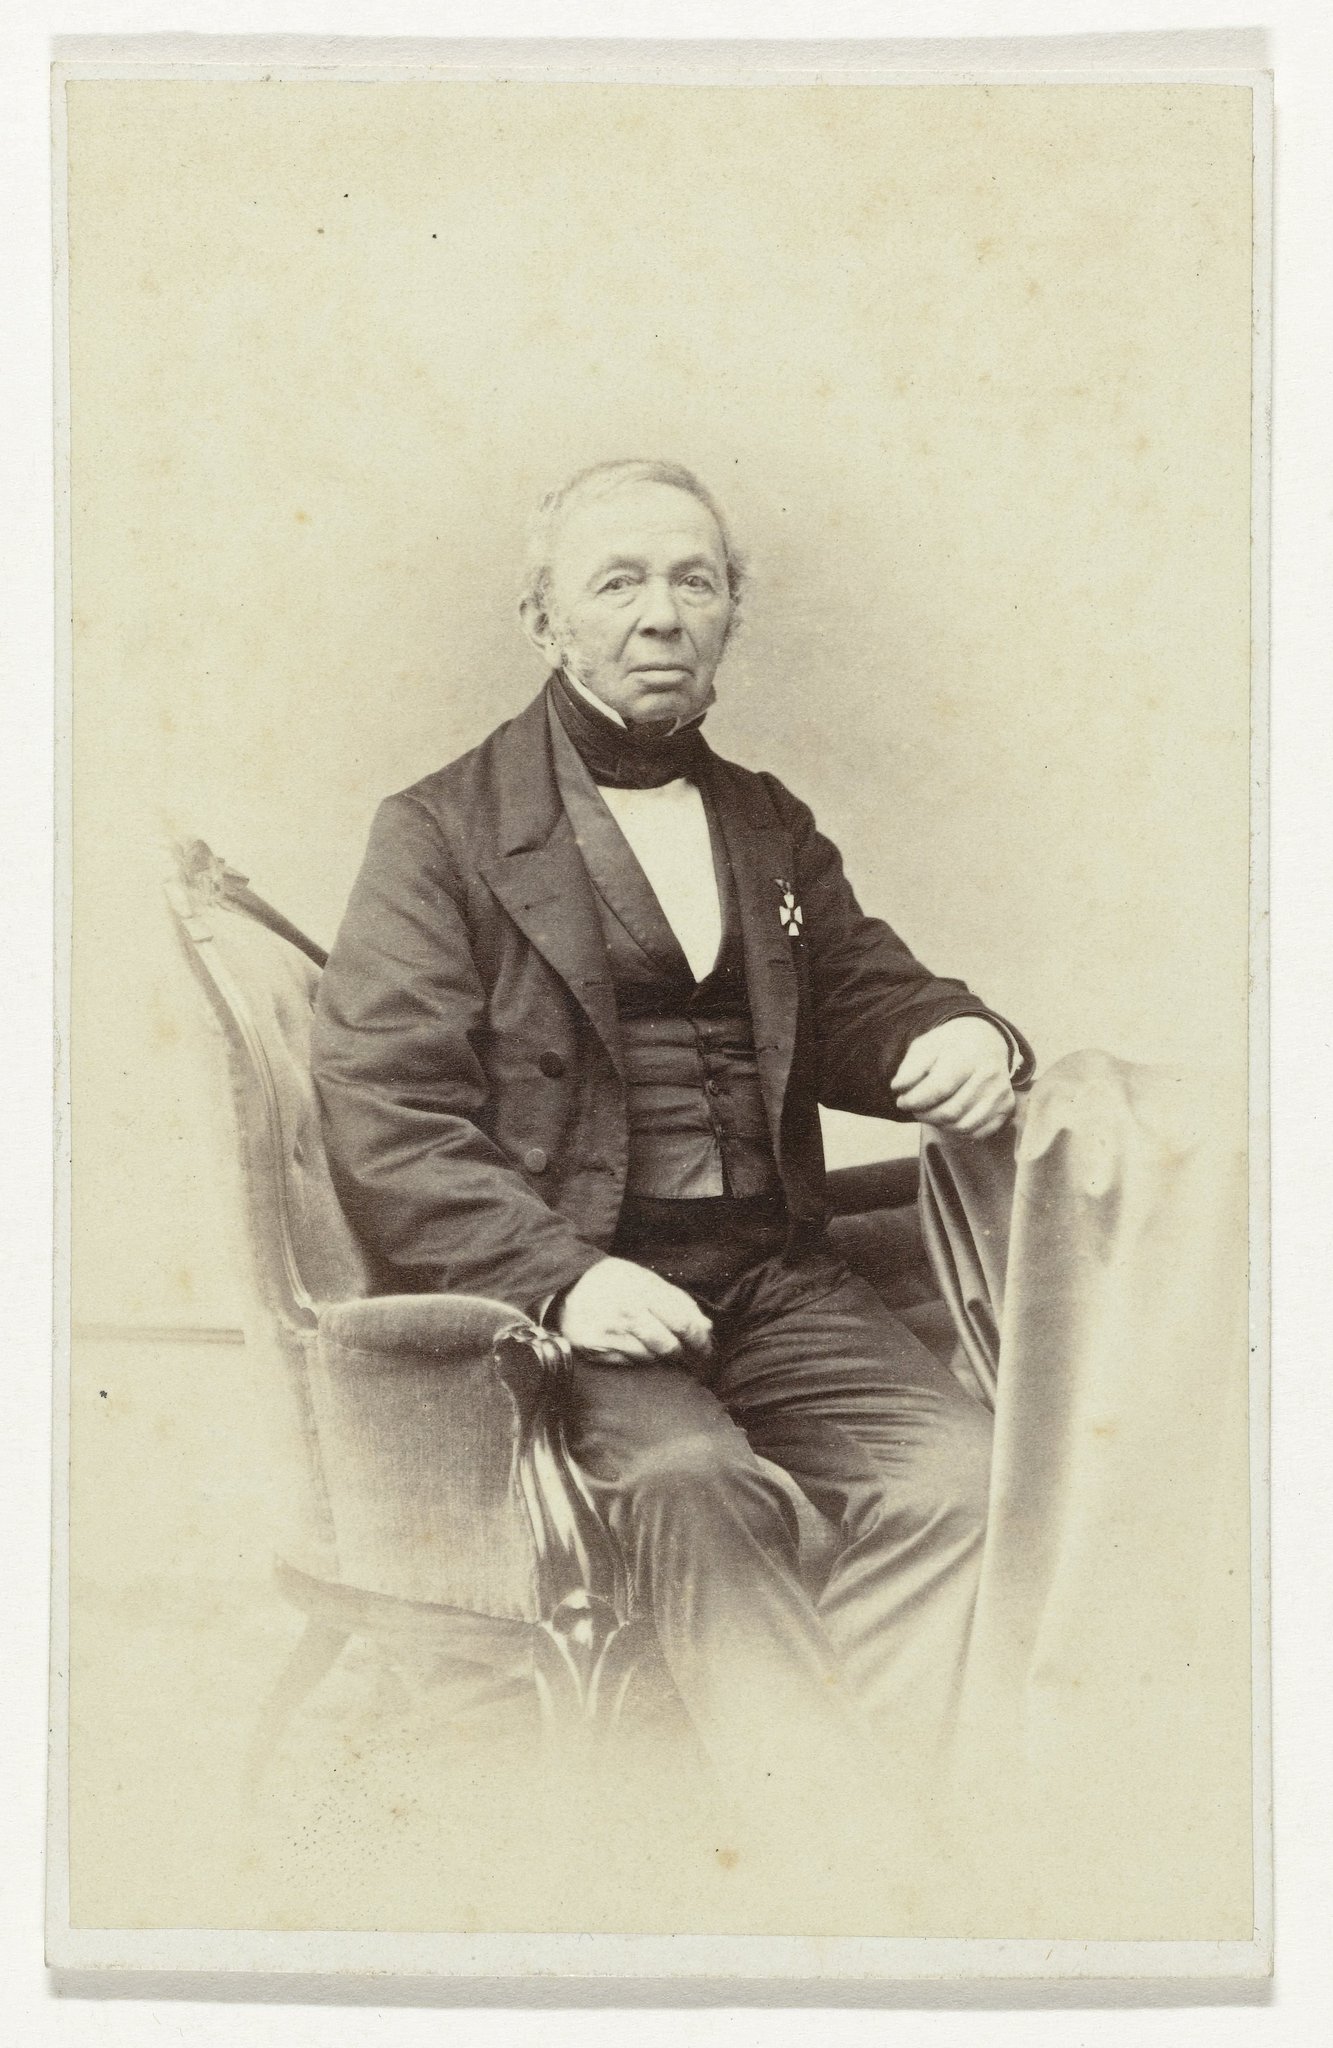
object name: carte de visite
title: Portret van een man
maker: johannes hinderikus egenberger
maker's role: draughtsman, print maker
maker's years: 1822-1897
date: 1865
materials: cardboard, paper, photographic support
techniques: albumen print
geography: groningen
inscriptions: annotation: ‘Oom Herman/Hora Siccama’, address: ‘J.H. Egenberger/Groningen’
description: Oudere man met ridderorde, zittend aan aan tafel, kniestuk.